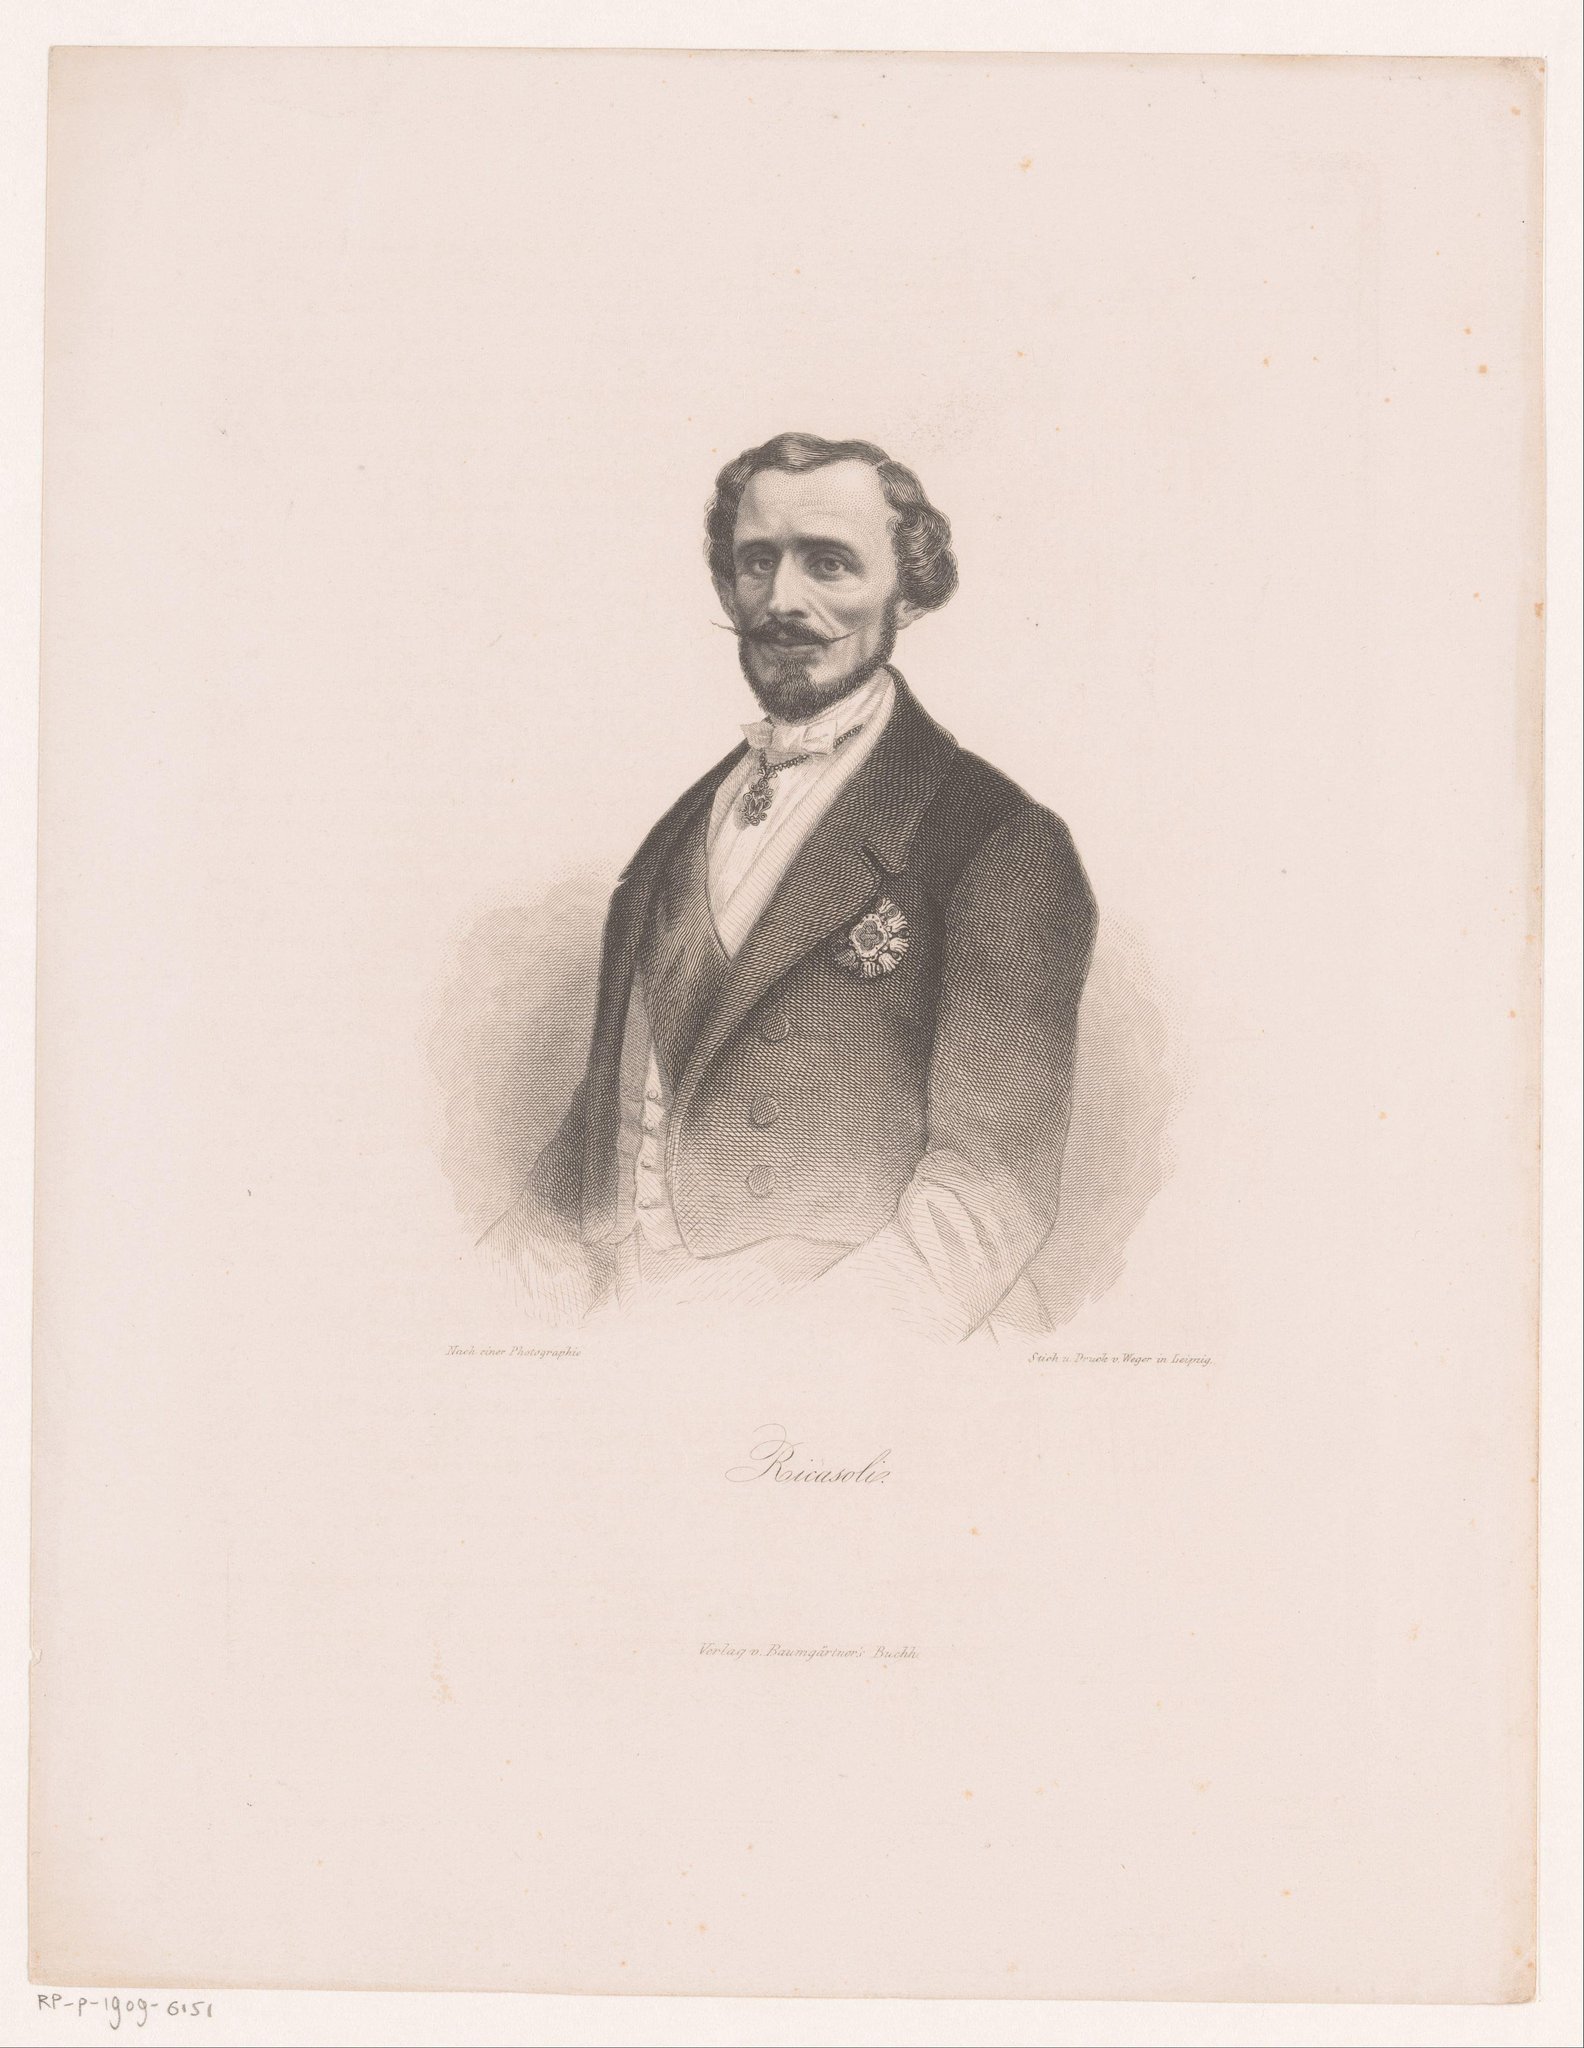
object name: print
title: Portret van Bettino Ricasoli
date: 1849-1892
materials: paper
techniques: engraving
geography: leipzig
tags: politician, mayor, historical persons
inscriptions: collector's mark: Lugt 2228